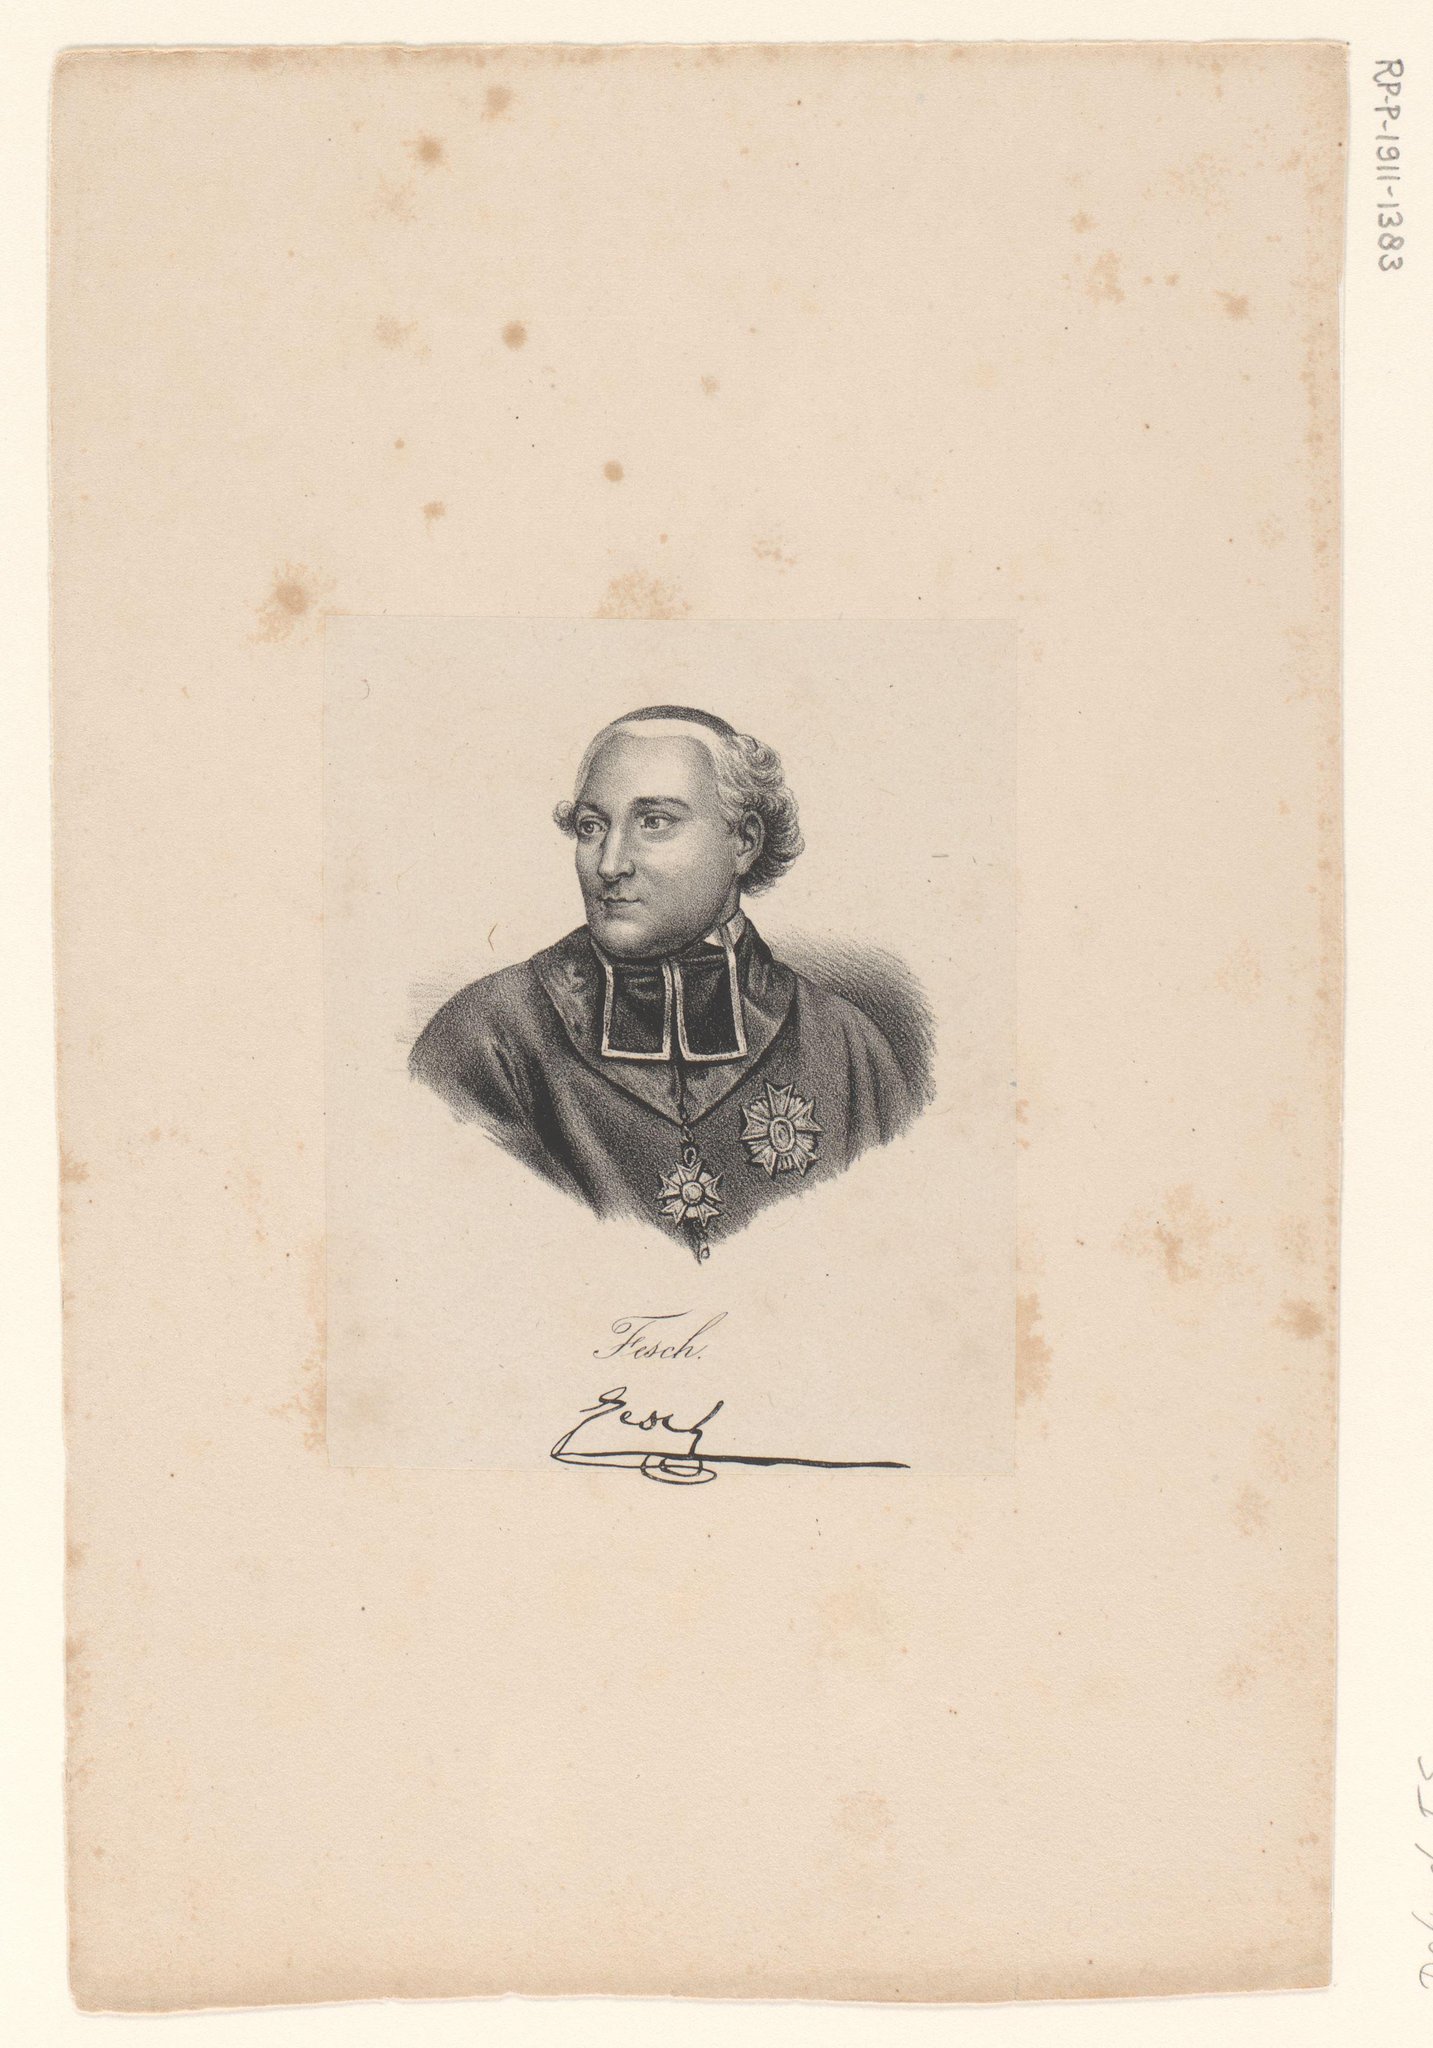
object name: print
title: Fesch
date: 1818-1842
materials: paper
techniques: lithograph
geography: paris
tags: historical persons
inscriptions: collector's mark: Lugt 2228a